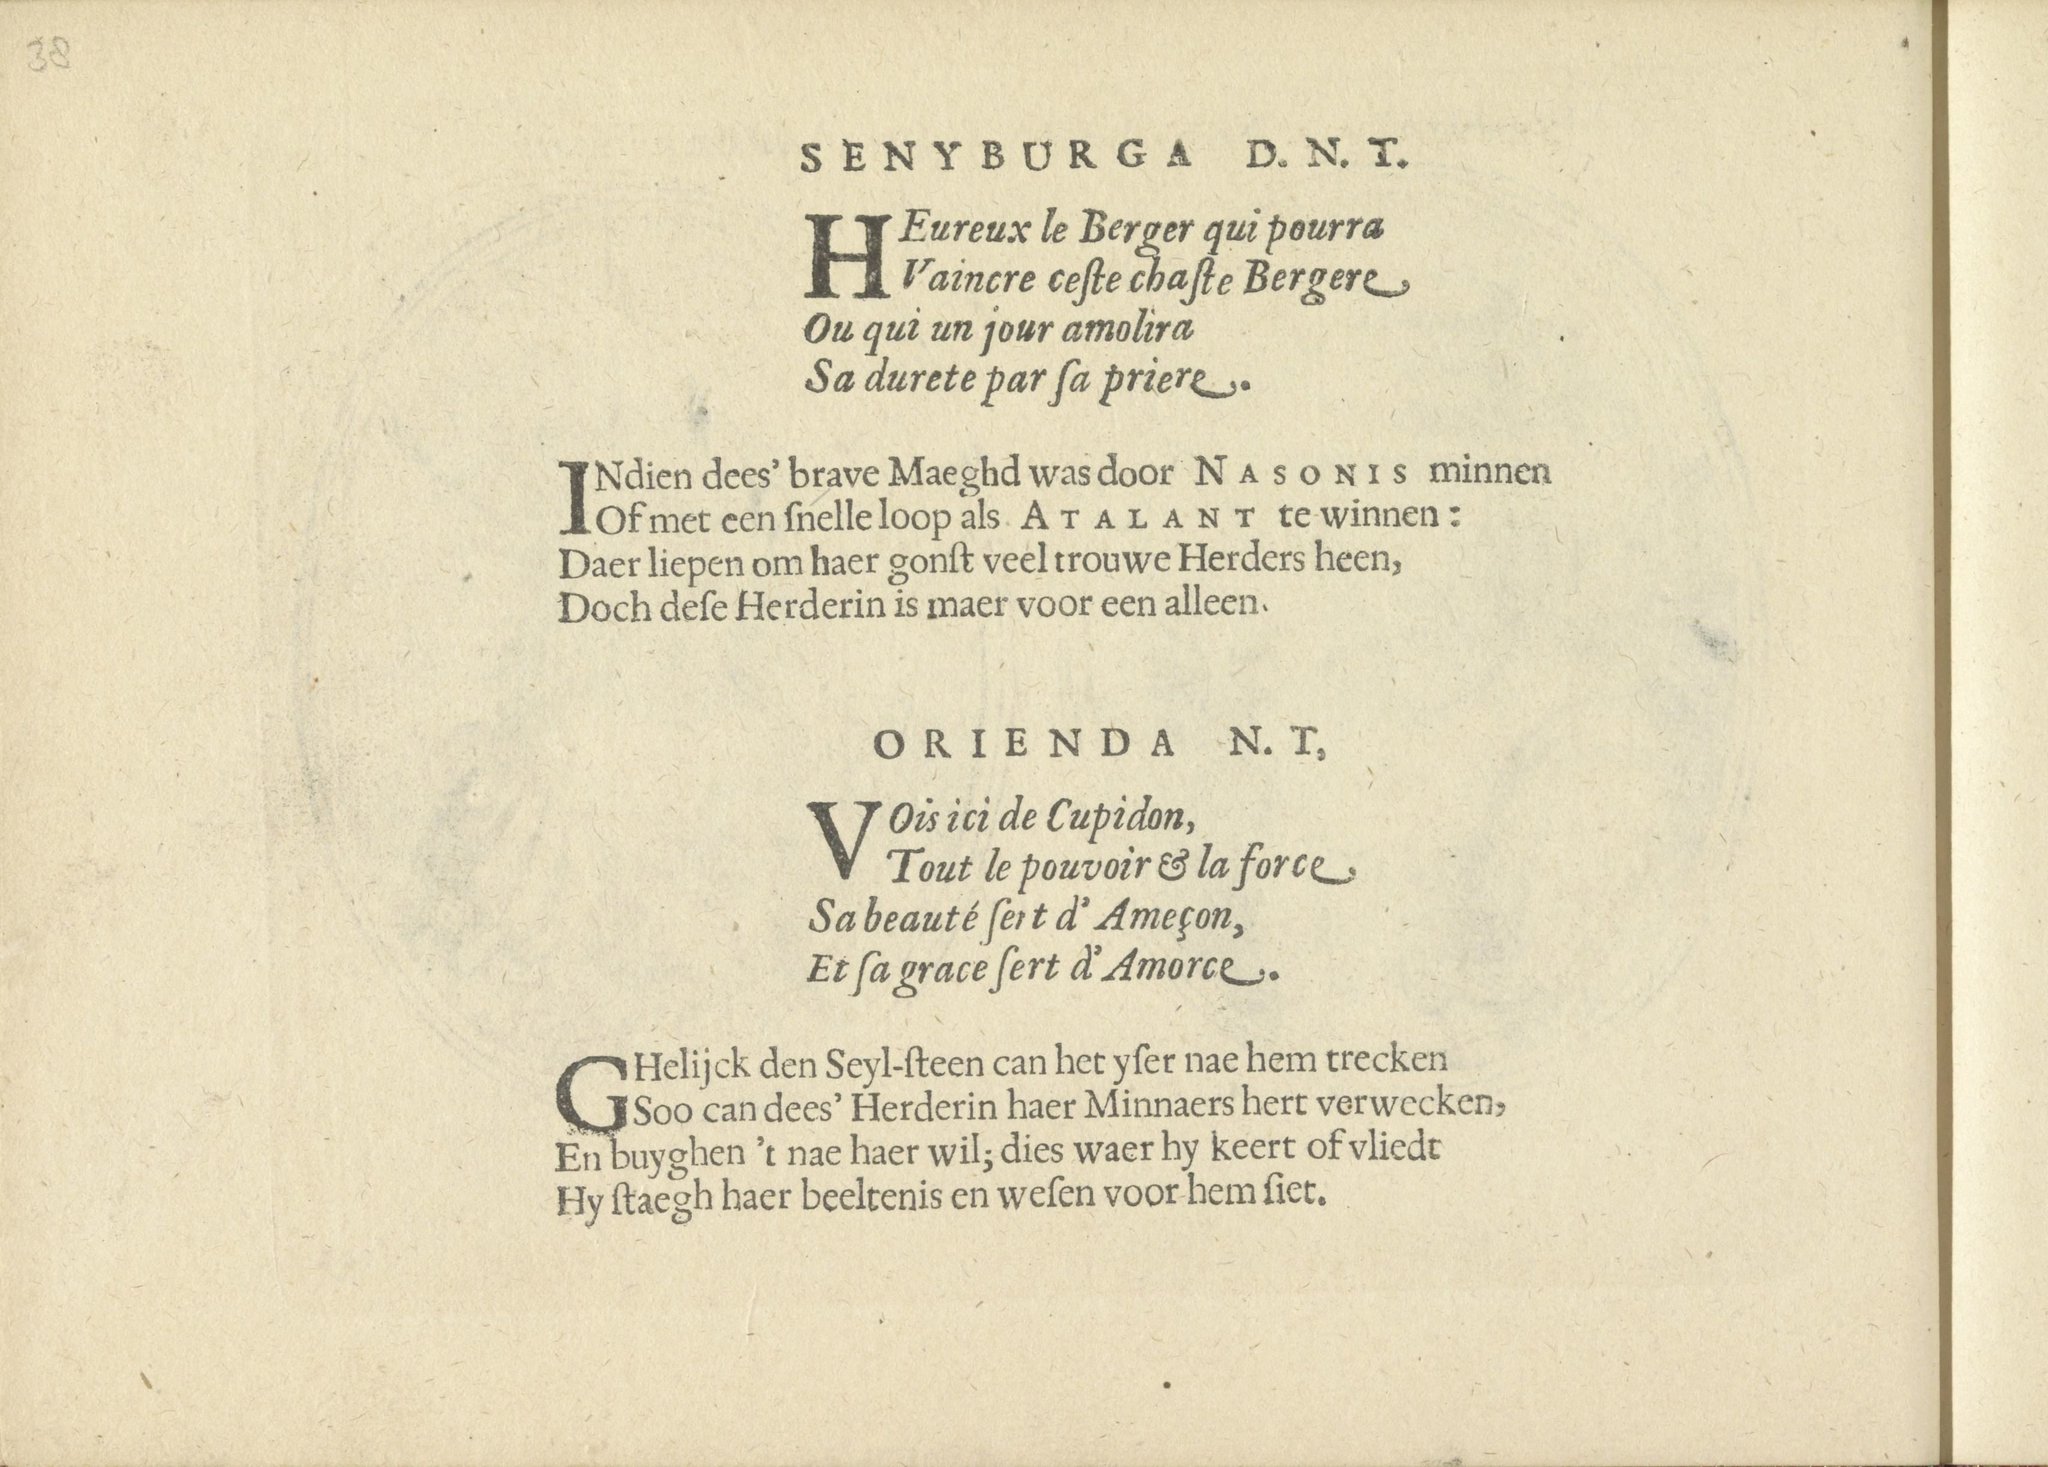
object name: album leaf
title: Kwatrijnen bij de voorstellingen van Senyburga D.N.T. en Orienda N.T.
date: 1640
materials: paper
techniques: letterpress printing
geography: amsterdam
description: Twee keer twee kwatrijnen in het Frans en Nederlands bij de voorstellingen van Senyburga D.N.T. en Orienda N.T. Het blad maakt deel uit van een album.